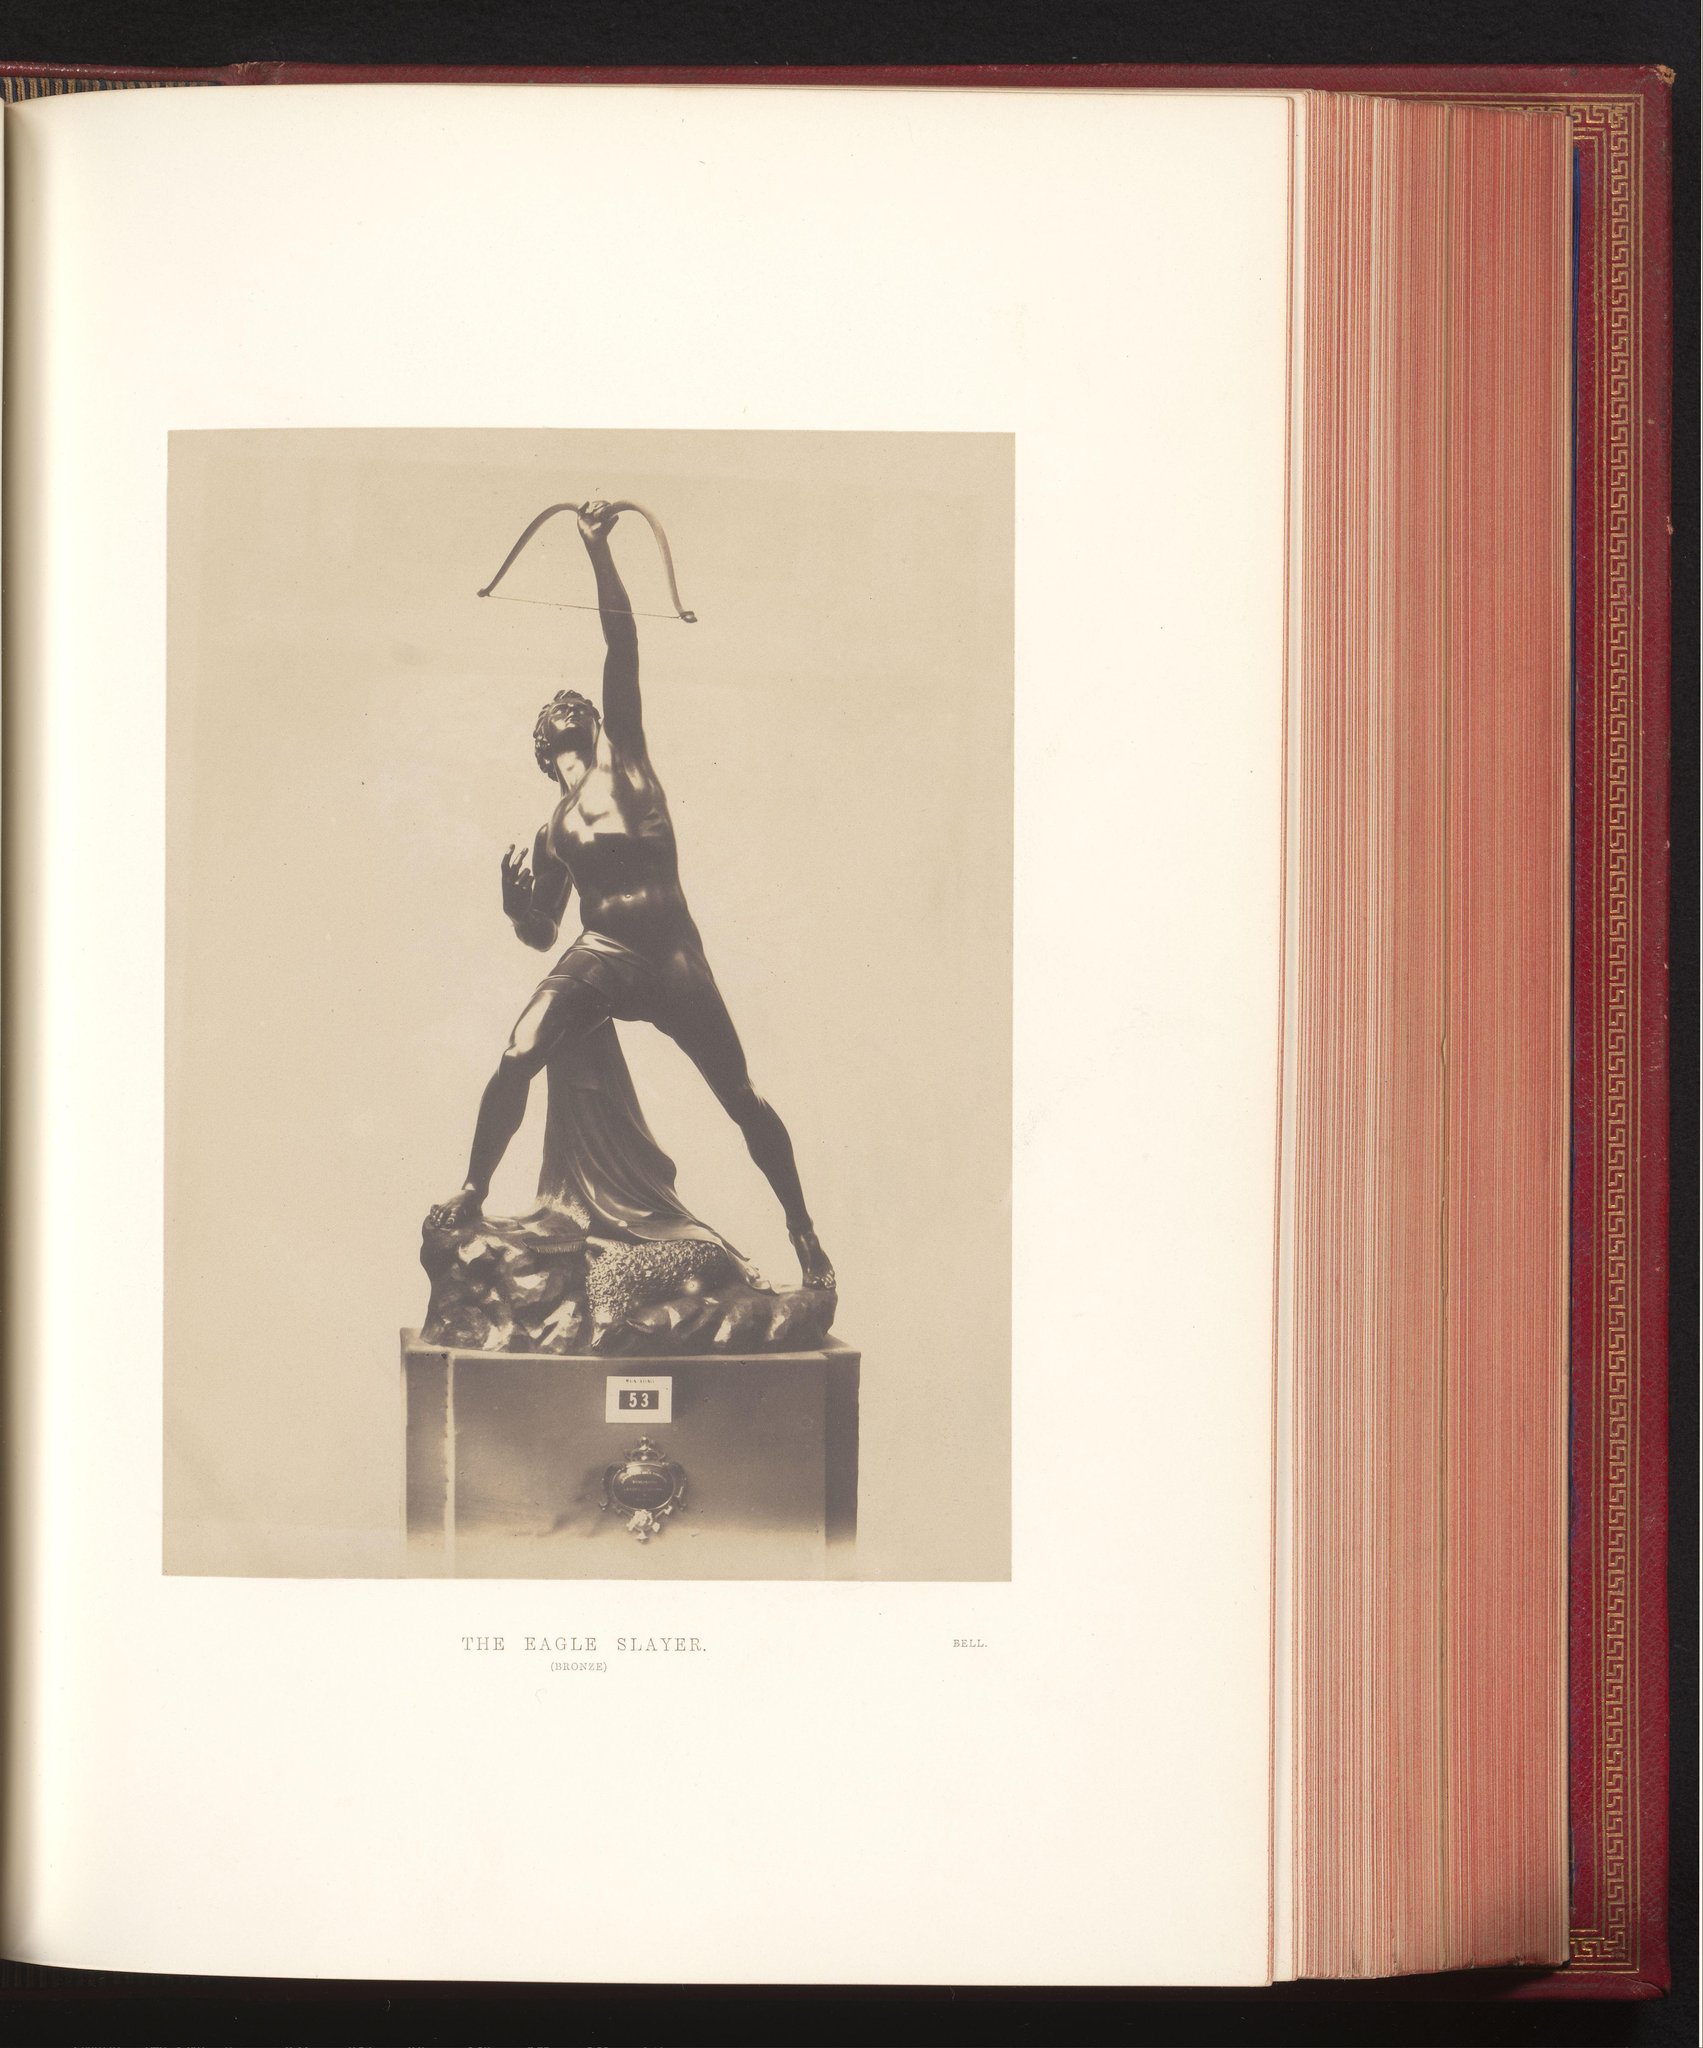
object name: page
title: Sculptuur door John Bell, voorstellend een adelaarjager, tentoongesteld op de Great Exhibition of the Works of Industry of All Nations van 1851 in Londen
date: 1851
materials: photographic support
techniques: salted paper print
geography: london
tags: piece of sculpture, reproduction of a piece of sculpture, london